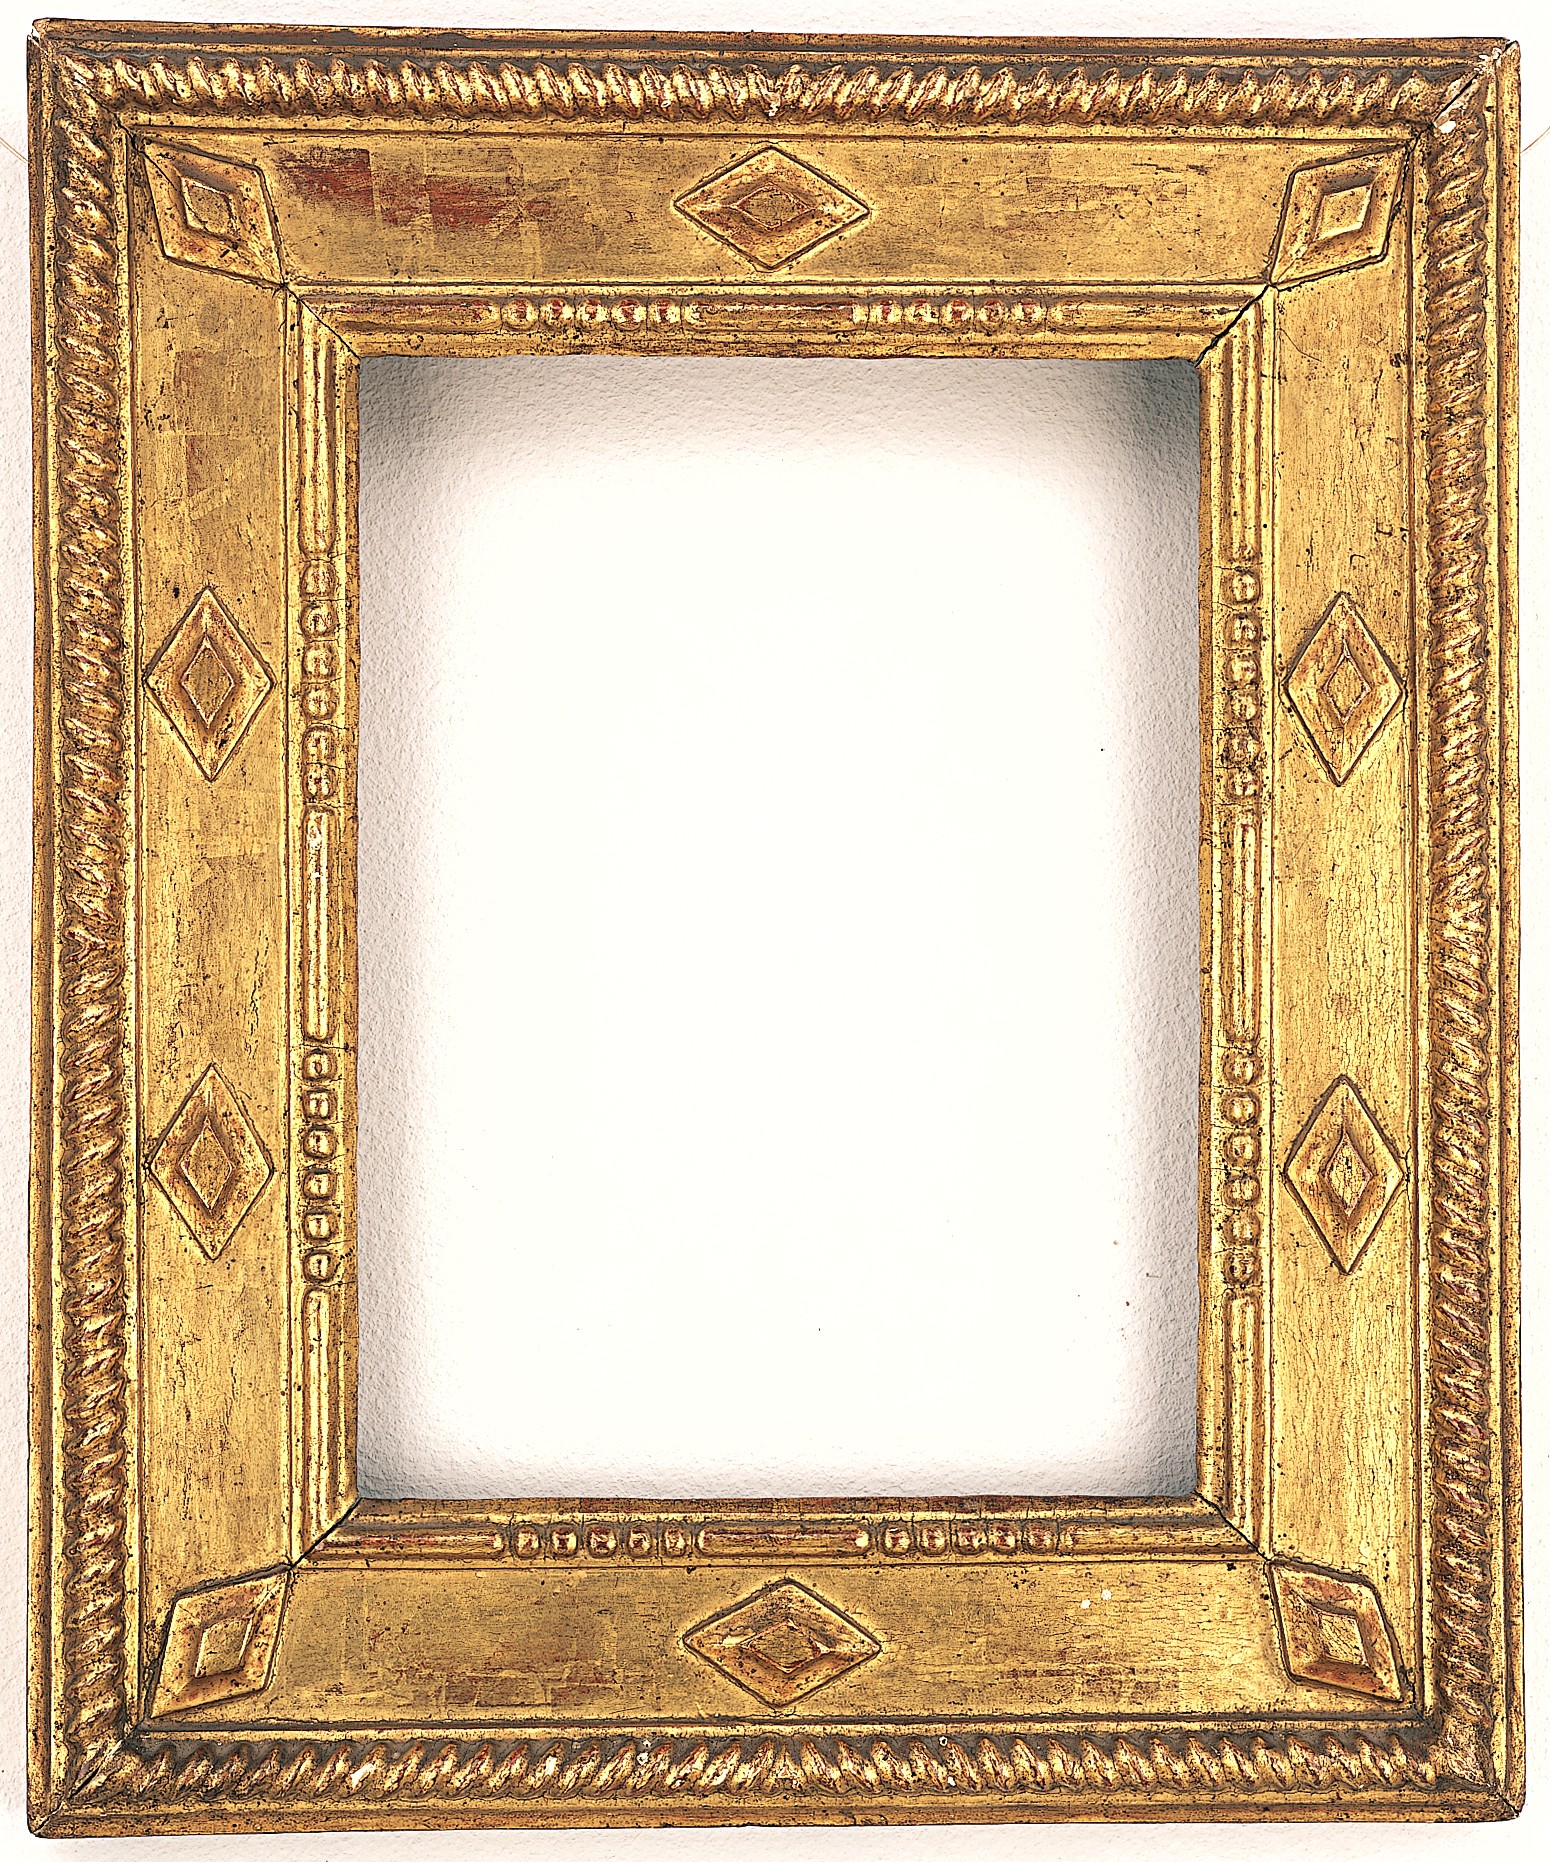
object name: frame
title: Cassetta frame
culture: spanish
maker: Anonymous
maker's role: artist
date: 1567-1633